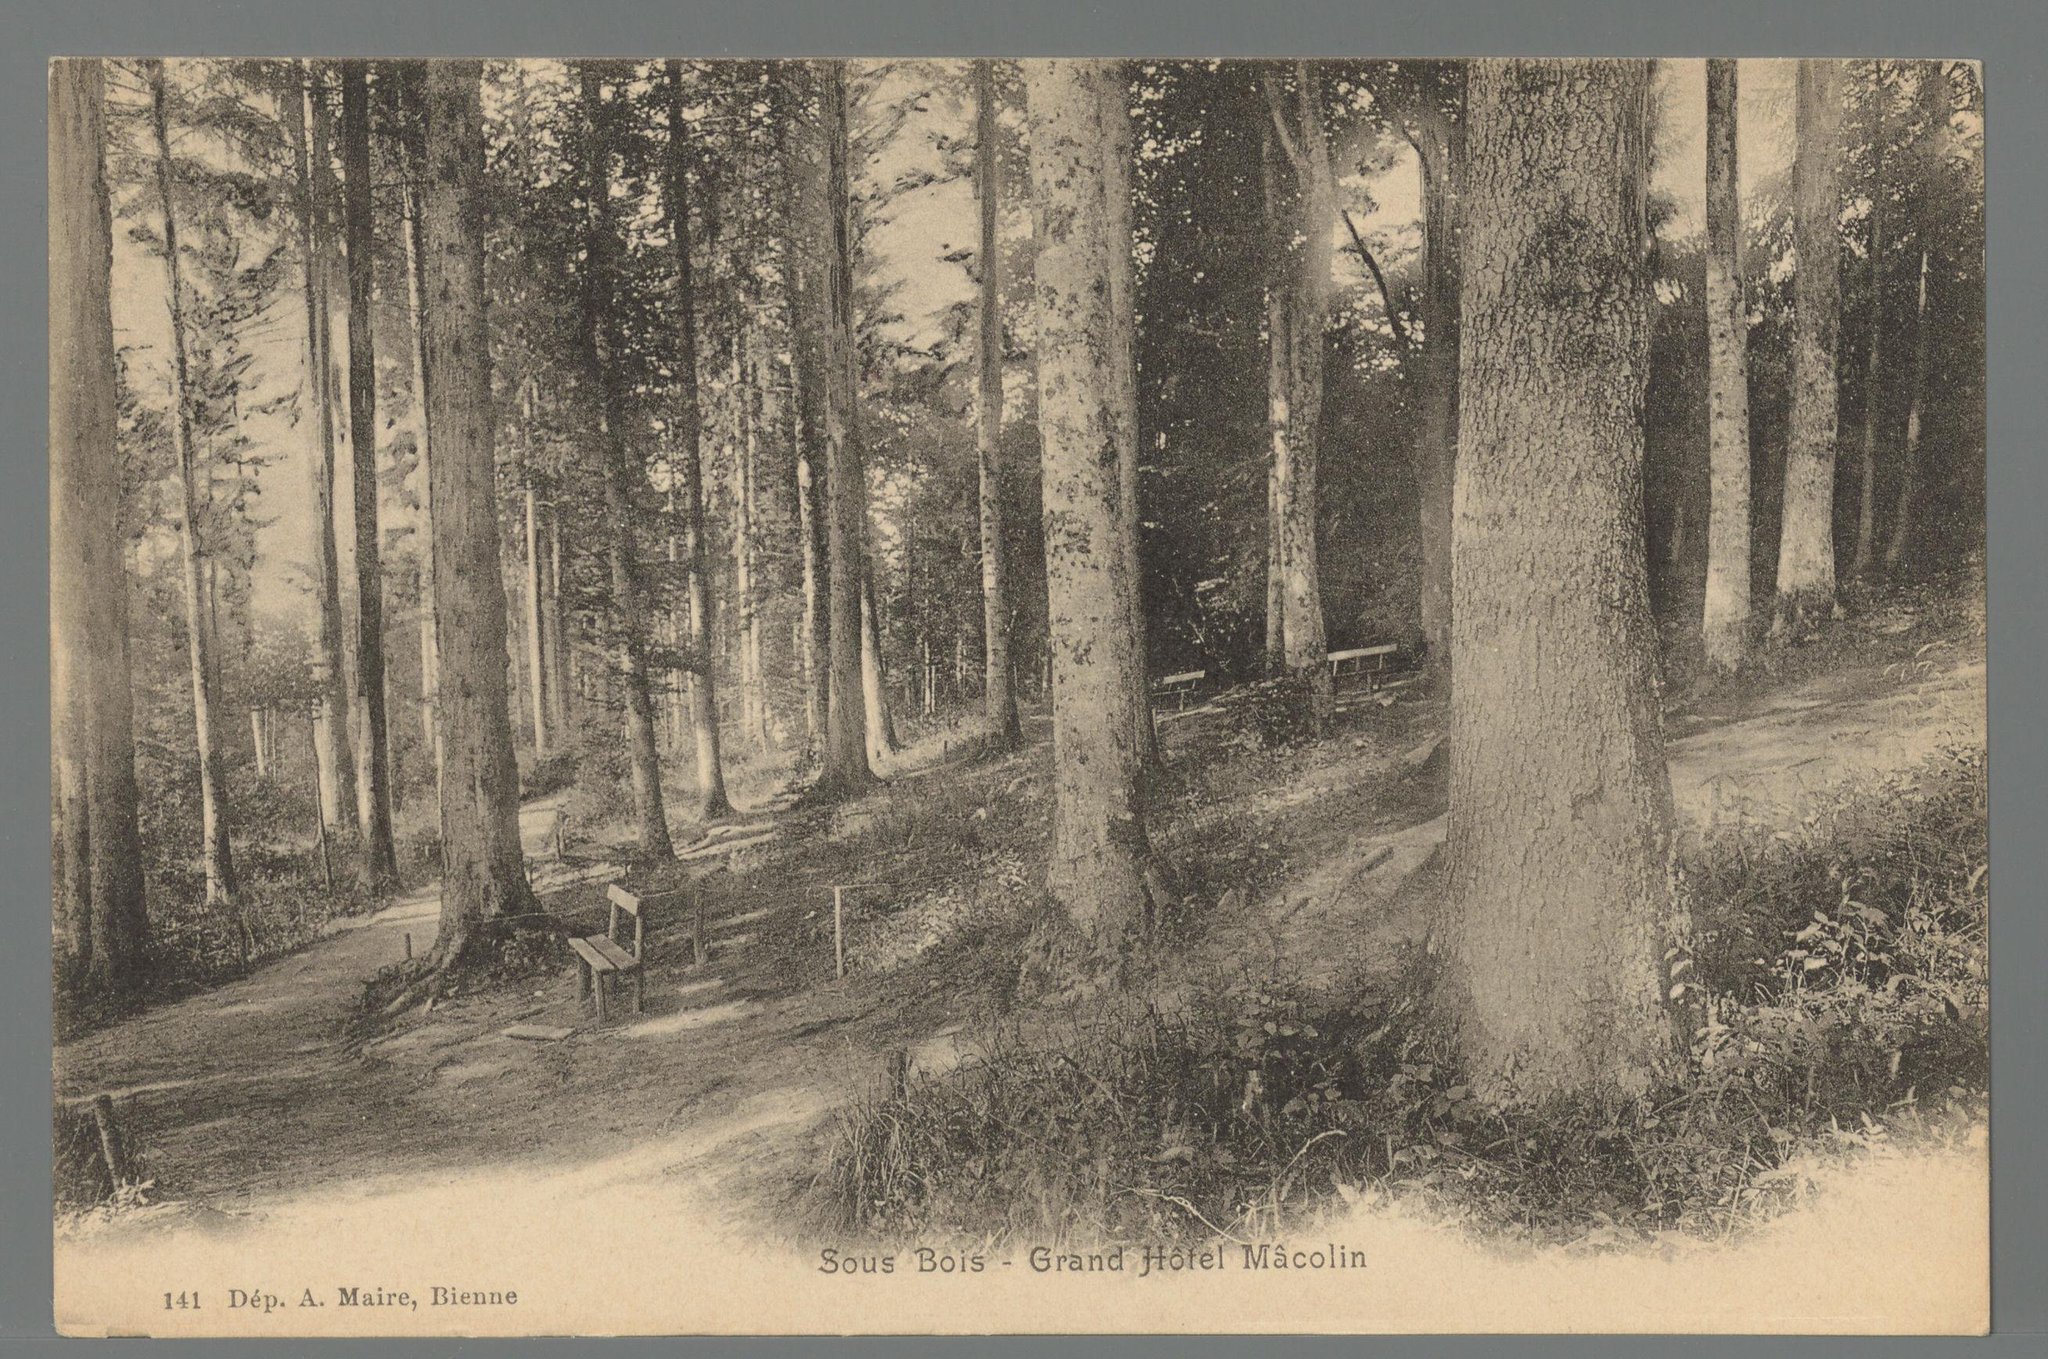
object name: photomechanical print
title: Sous-Bois. Grand Hôtel Mâcolin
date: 1890-1905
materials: cardboard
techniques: photograph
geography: magglingen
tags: forest path or lane